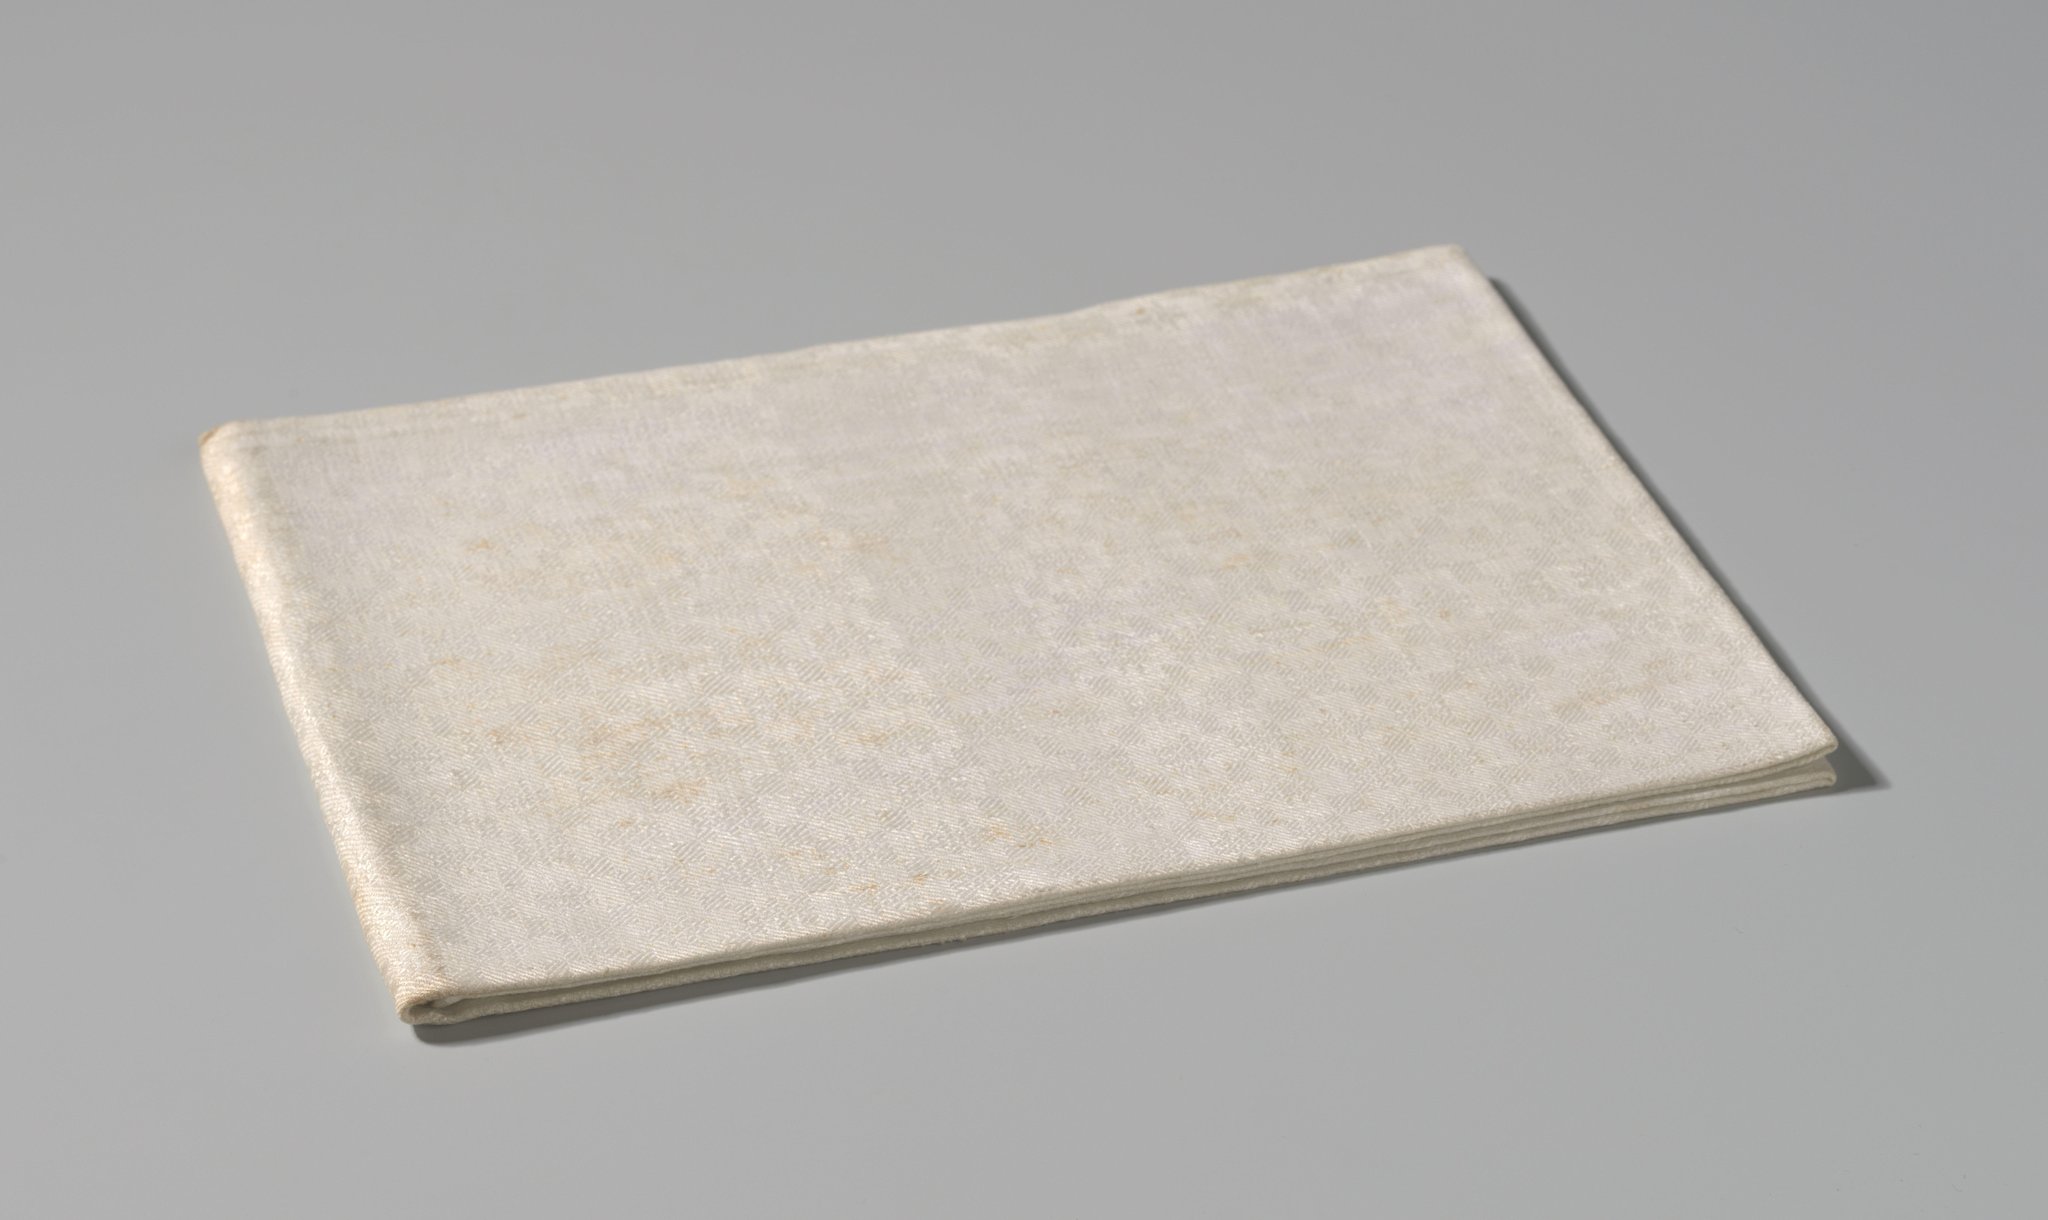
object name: napkin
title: Servet van linnendamast met pellenpatroon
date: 1756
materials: linen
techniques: twill, peeled fabric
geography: northern netherlands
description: Wit linnen servet met een pellenpatroon in keperbinding, merk WG 130 1756.